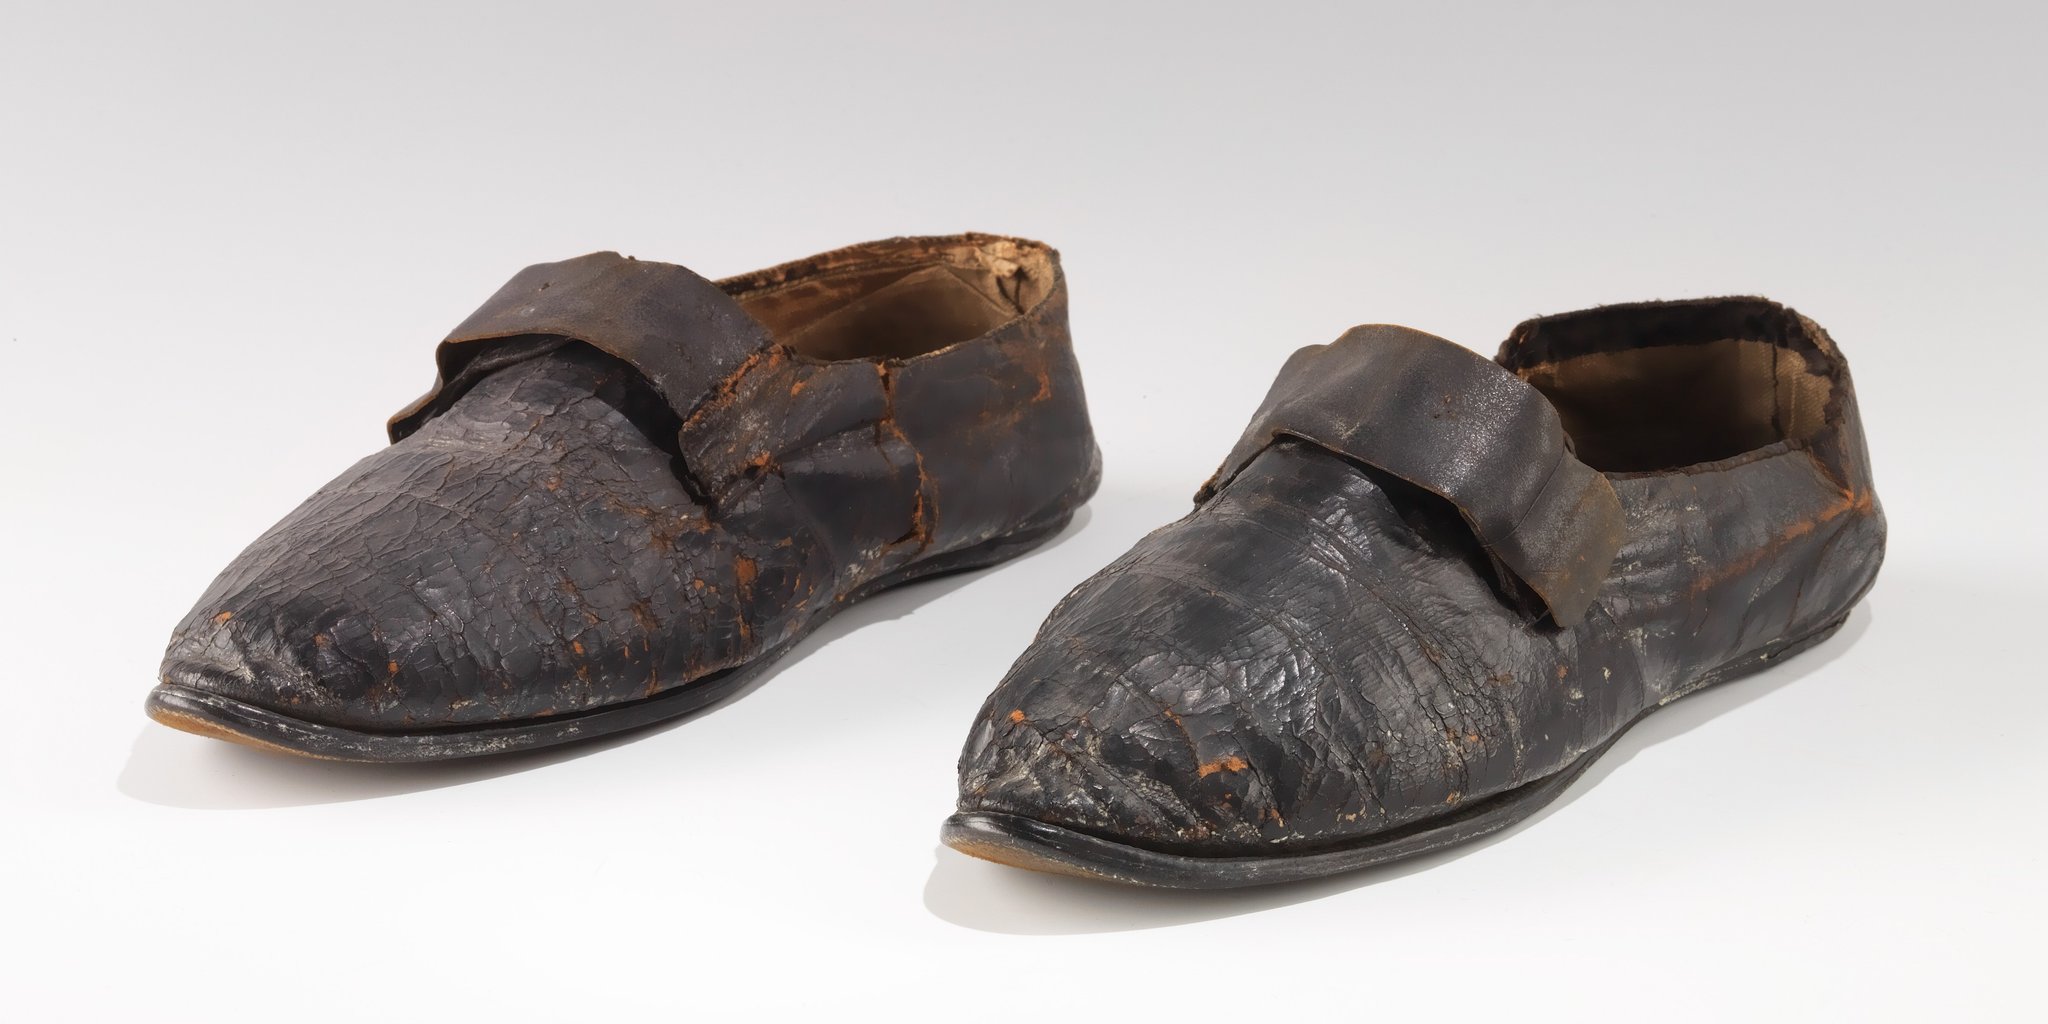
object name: shoe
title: Shoes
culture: british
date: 1790-1825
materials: leather